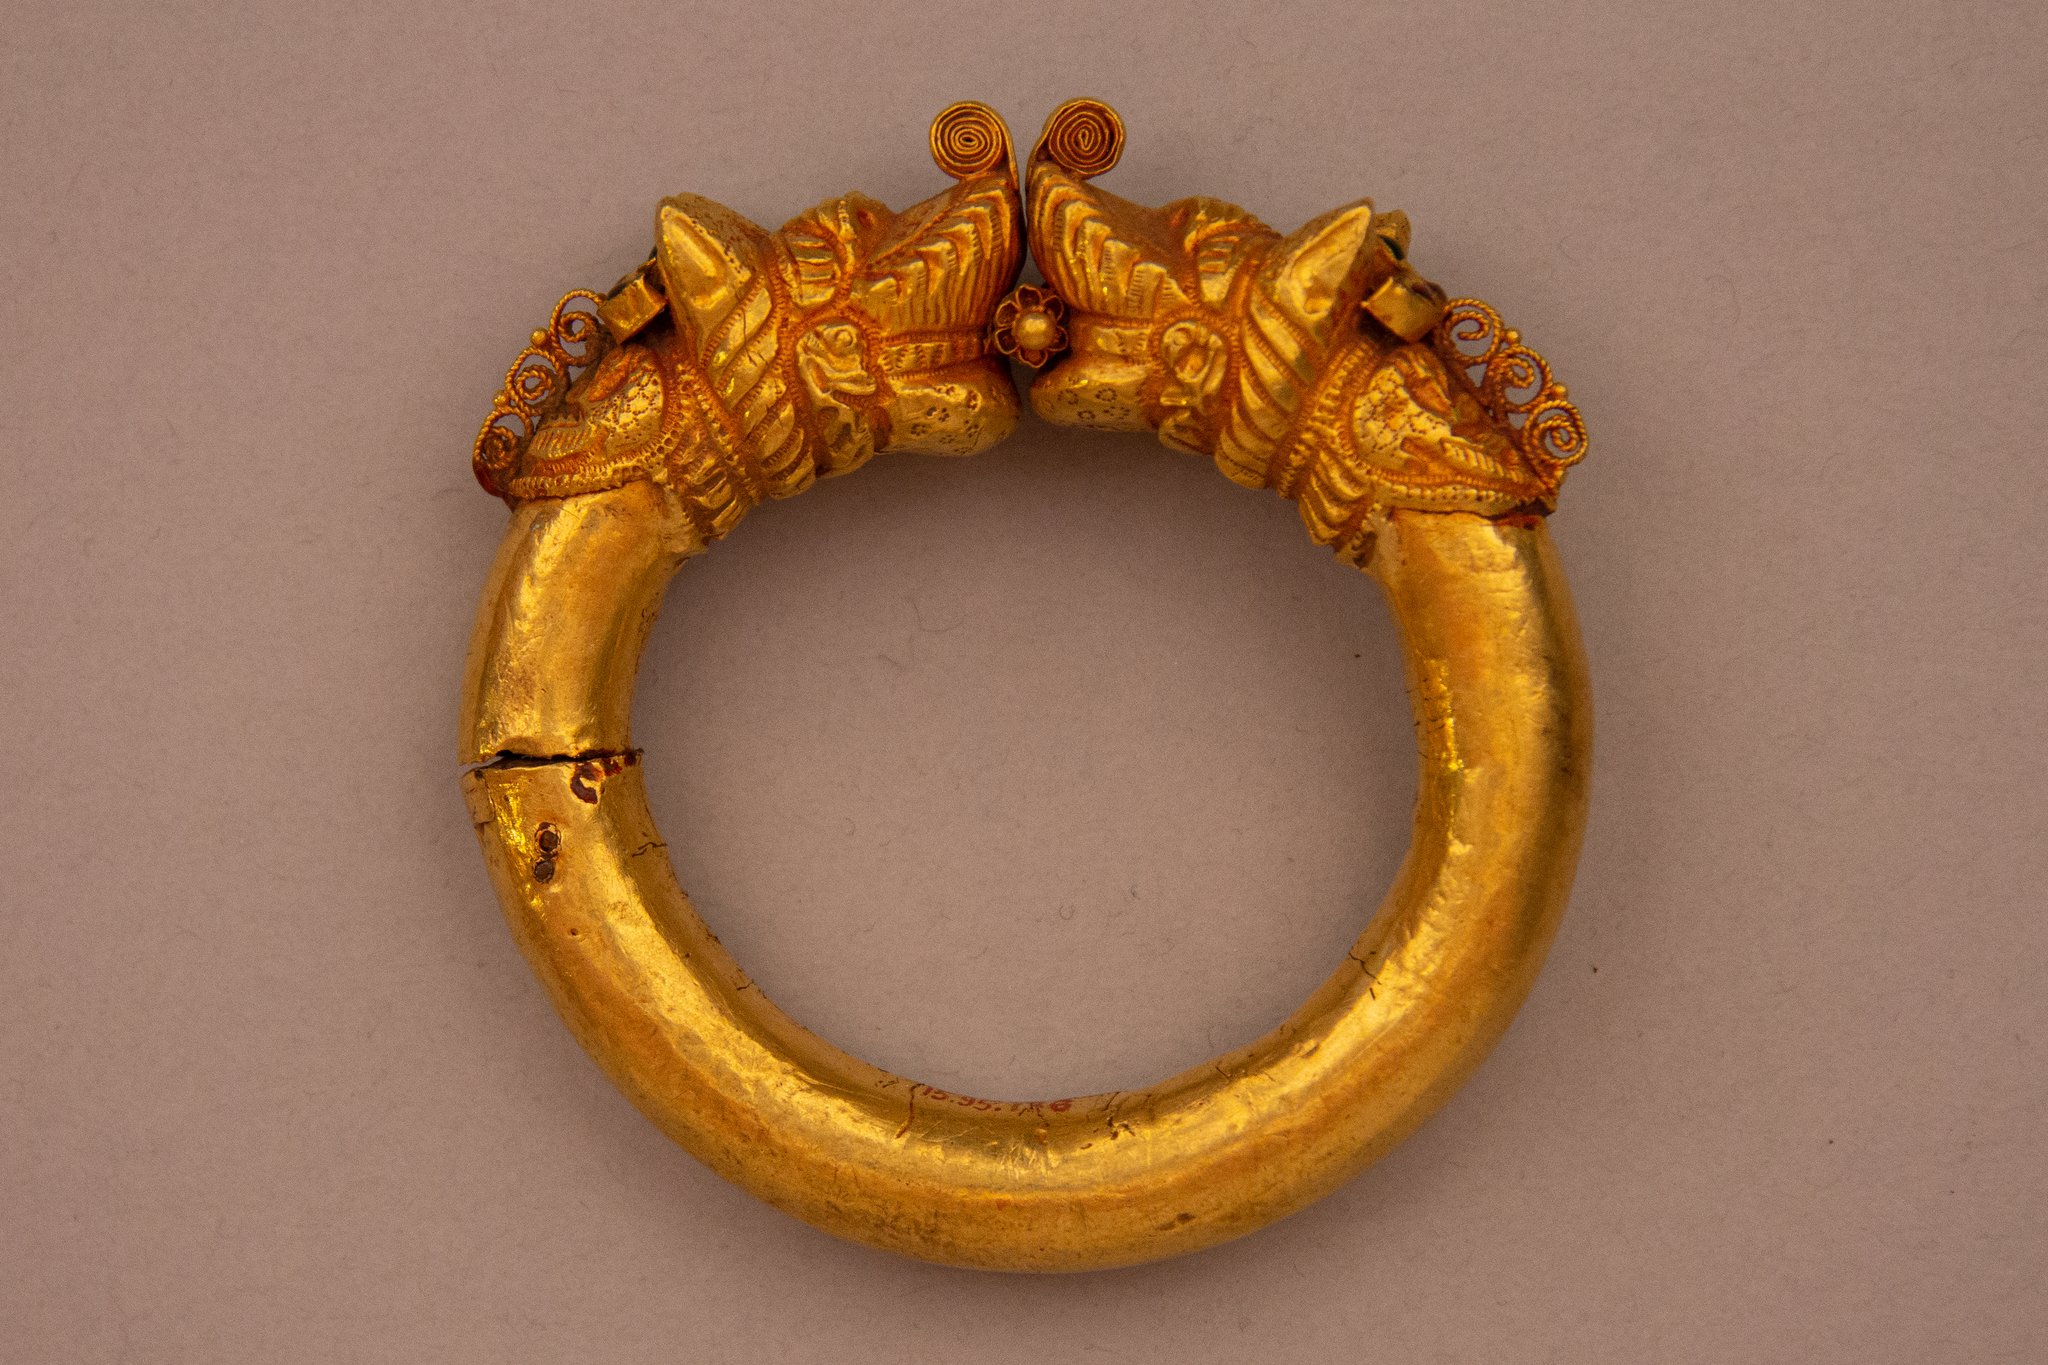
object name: bracelet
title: Bracelet (Kada), One of a Pair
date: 1801-1900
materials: gemstone, gold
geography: india